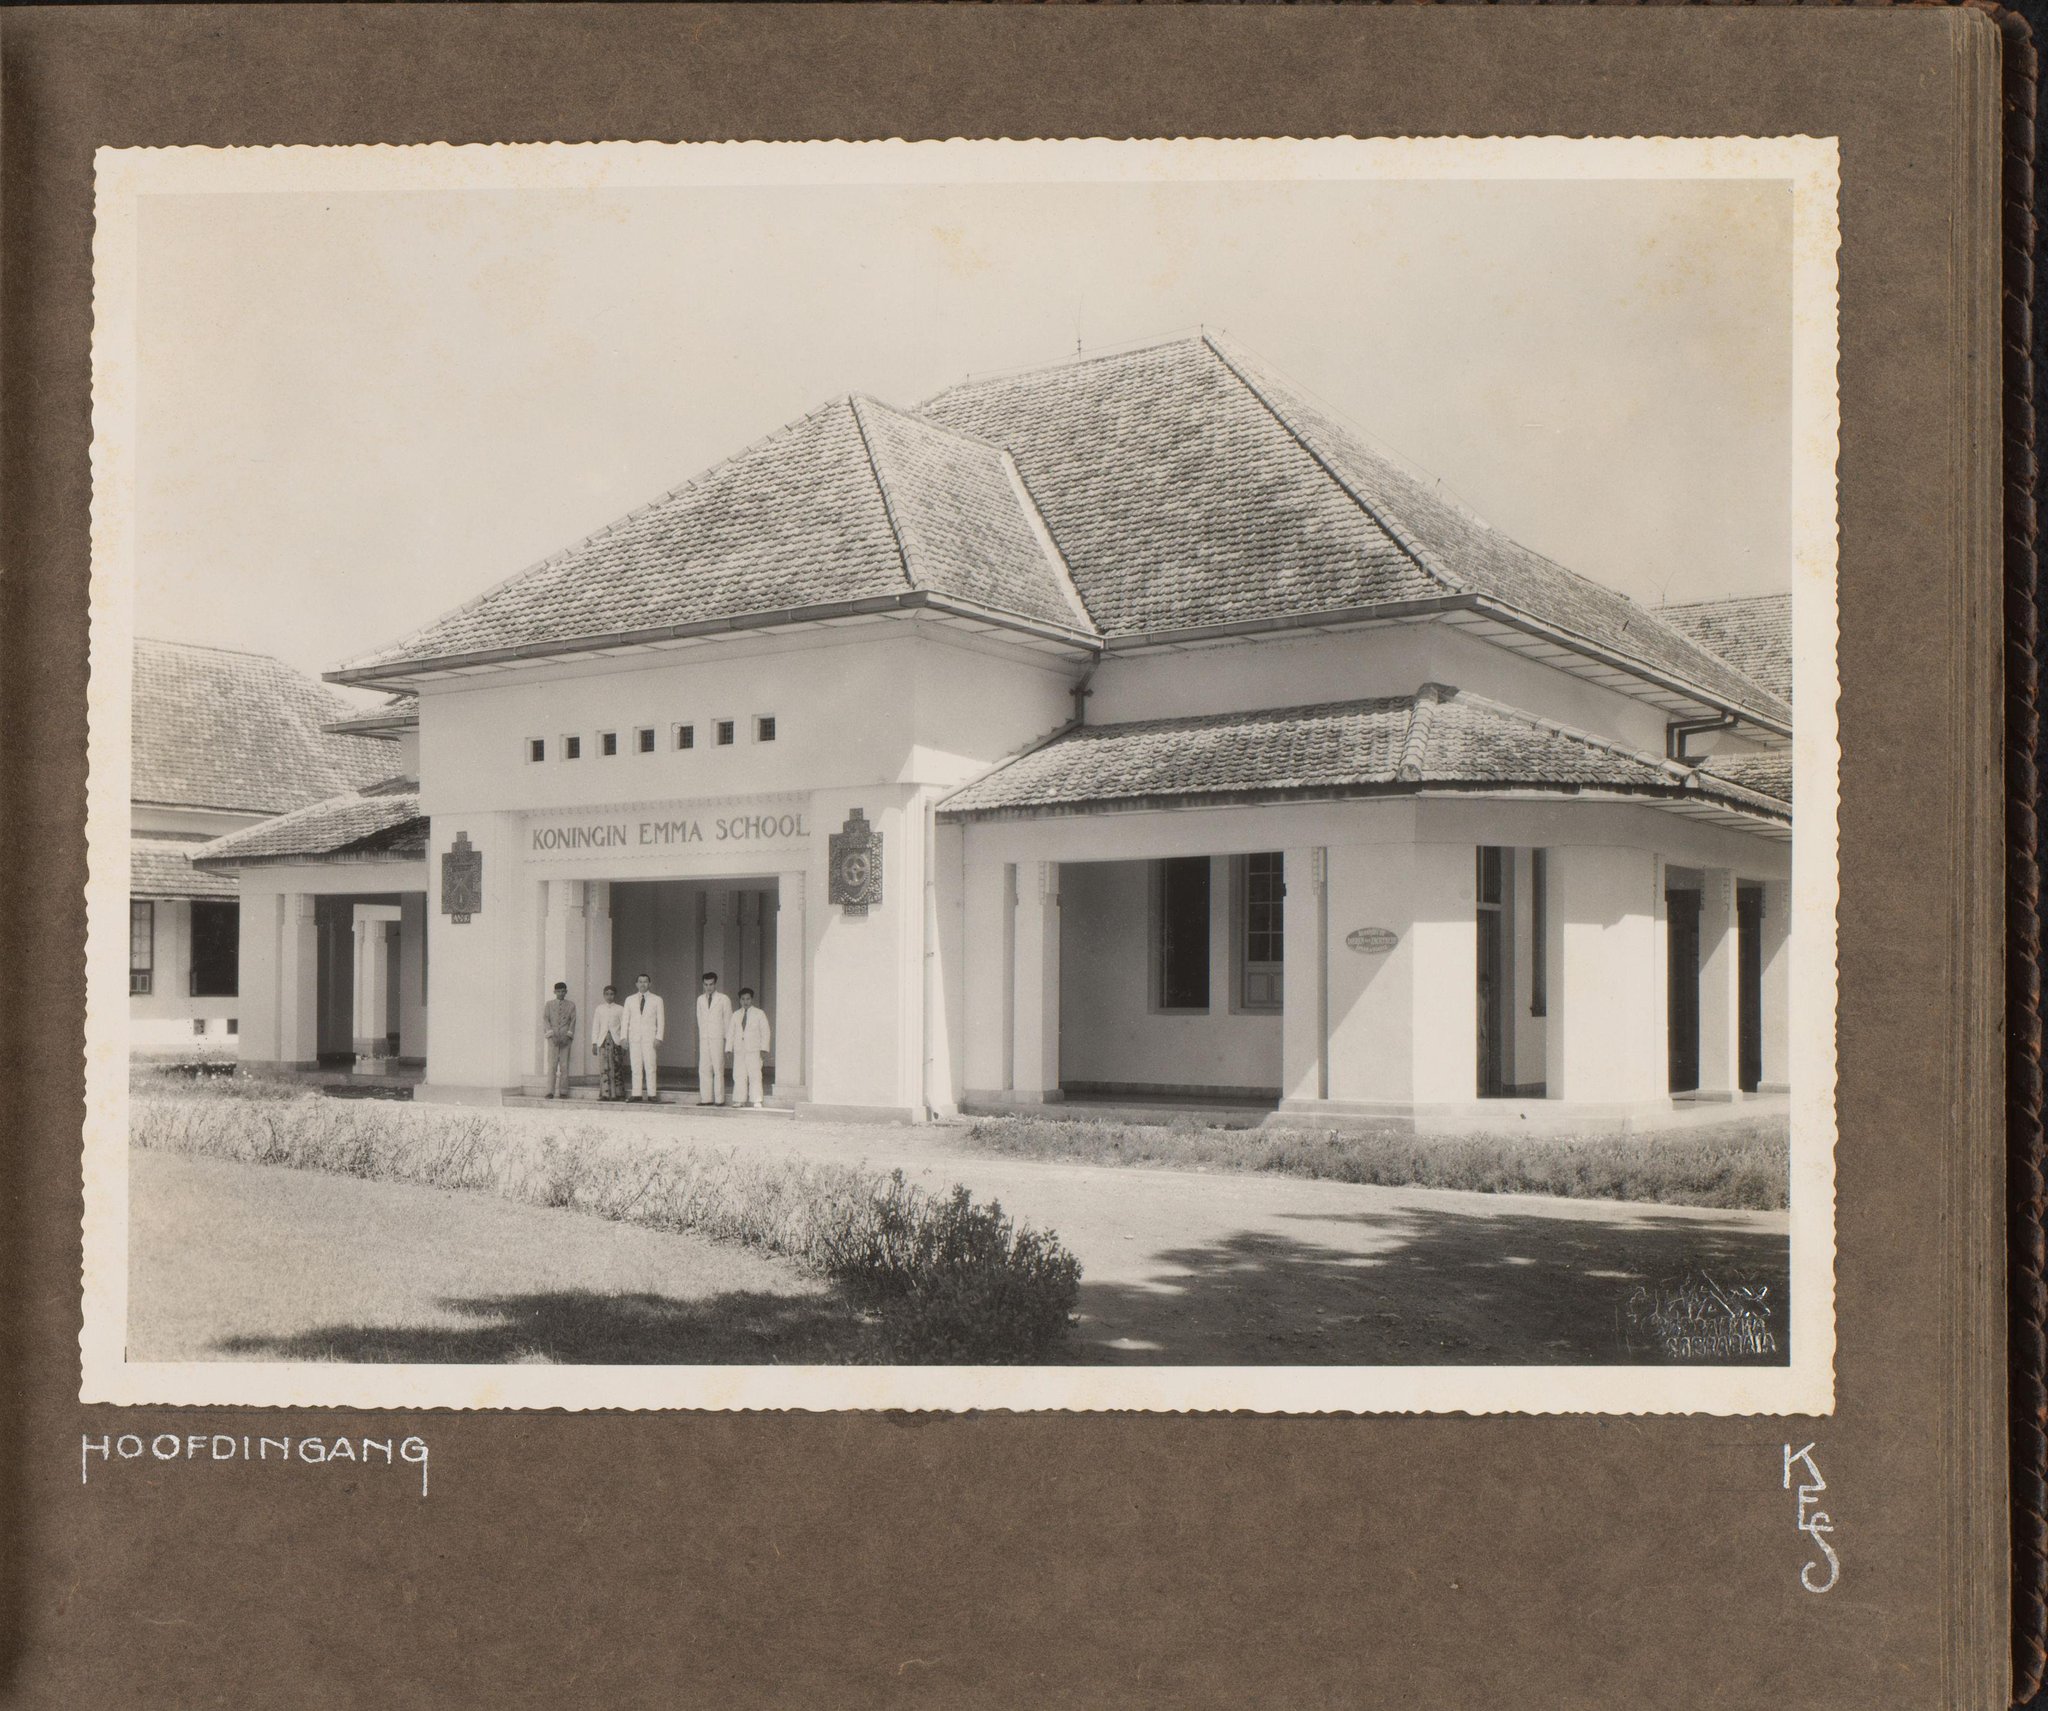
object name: photograph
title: Hoofdingang van de Koningin Emma School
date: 1933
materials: photographic support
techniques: gelatin silver print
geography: surabaya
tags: vocational education, e.g.: junior technical school (+ building ~ education, tuition), colonial government, dutch east indies, the, surabaya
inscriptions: inscription: ‘Hoofdingang / KES’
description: Hoofdingang van de Koningin Emma School te Soerabaja. Enkele personen poserend voor de ingang van de school. Foto ingeplakt in het fotoalbum aangeboden aan J.H.A. van der Hoeven bij het beëindigen op 31 juli 1933 van zijn diensttijd bij het Nijverheidsonderwijs in Nederlandsch-Indië.